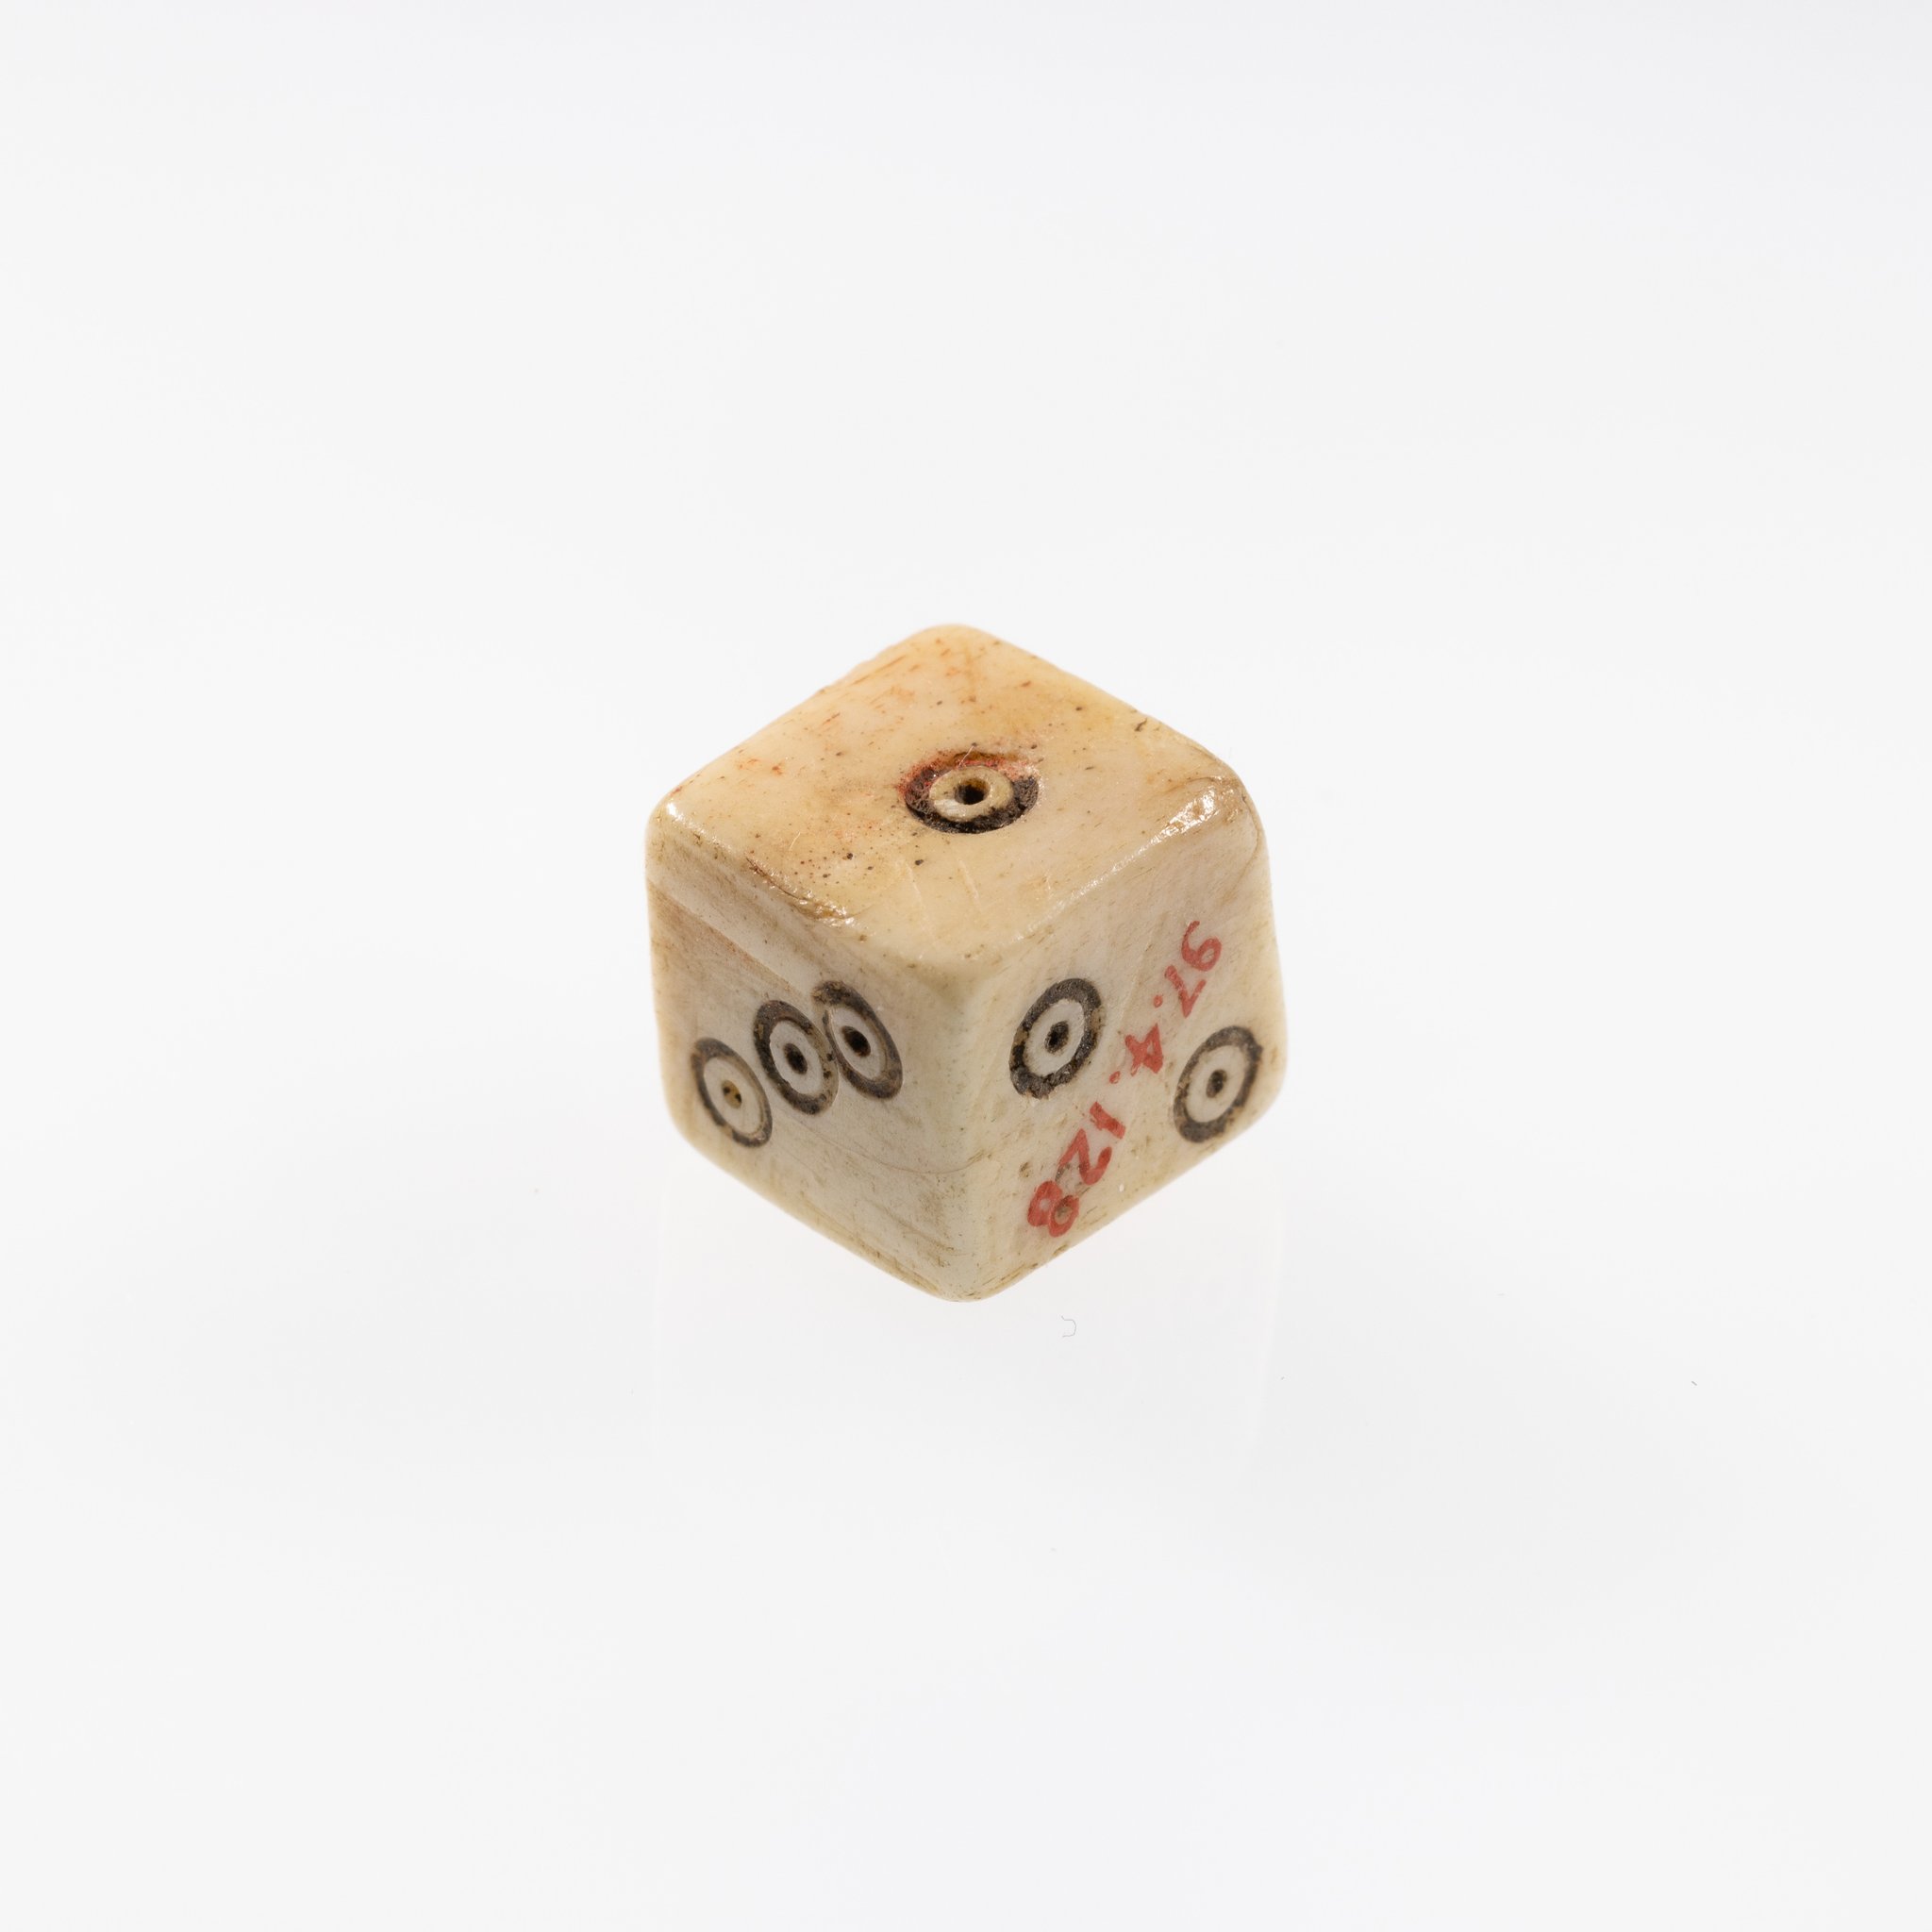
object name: dice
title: Die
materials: ivory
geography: egypt